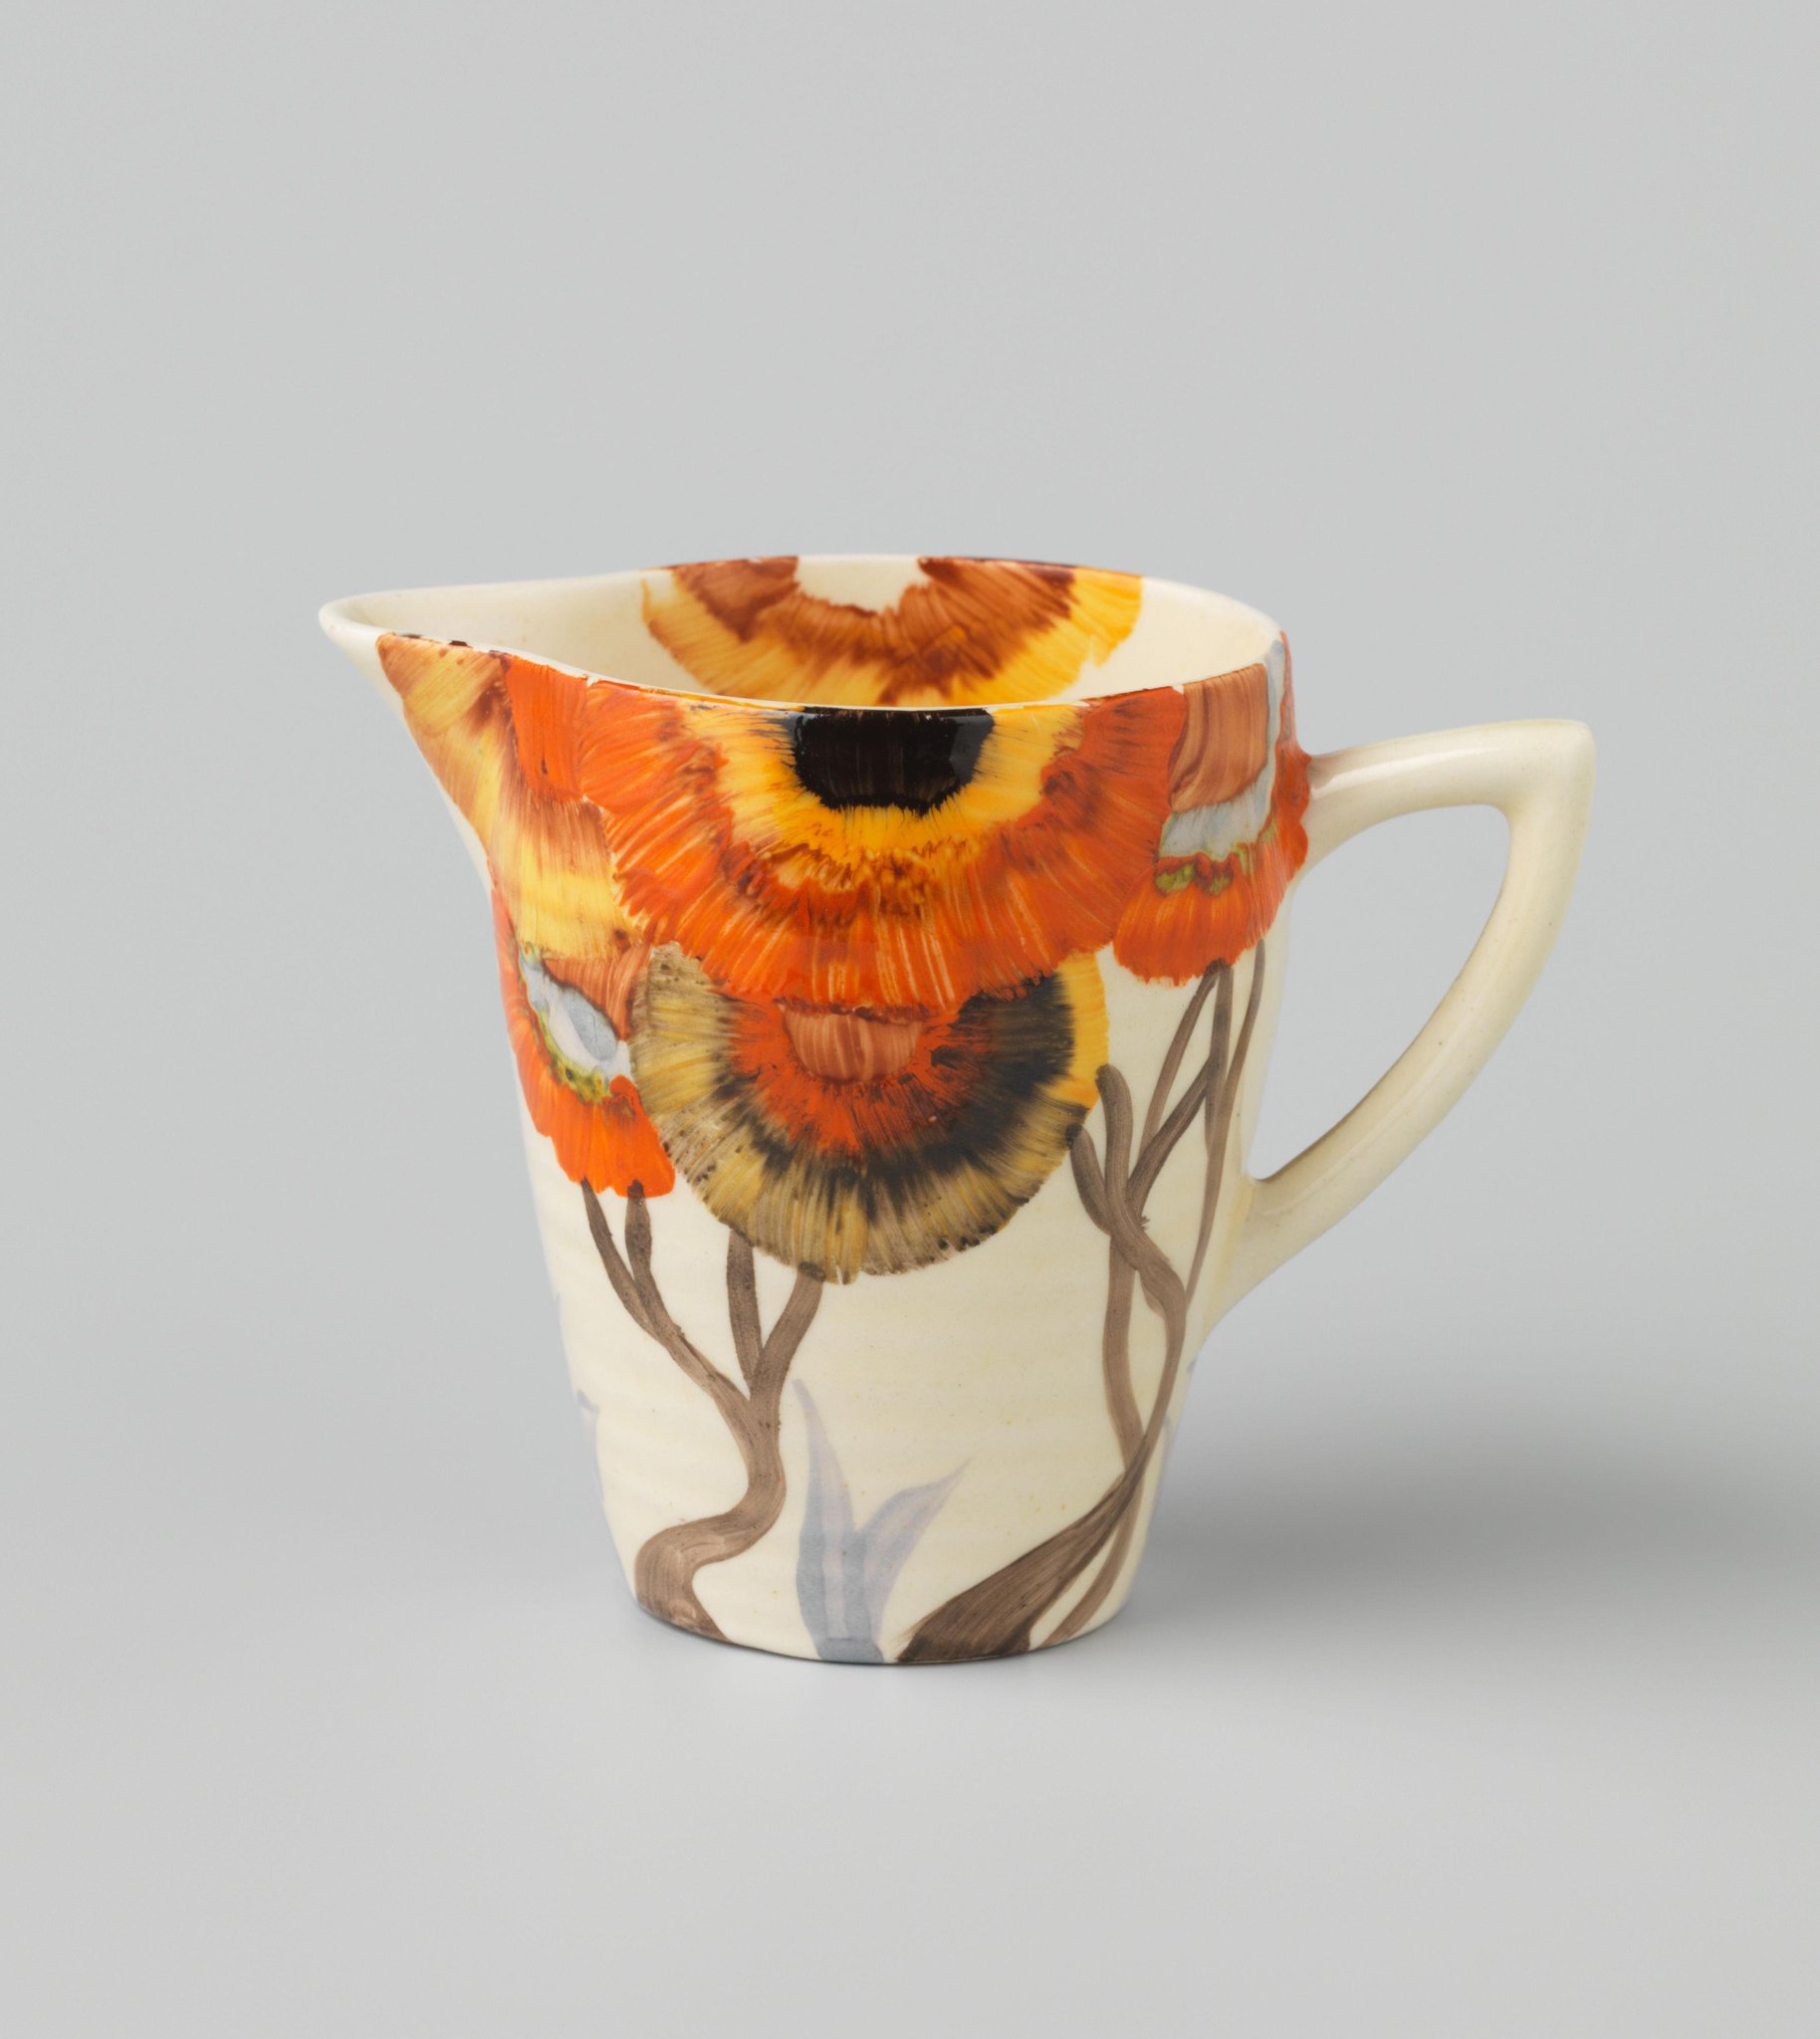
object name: milk jug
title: Melkkan met veelkleurig bloemendecor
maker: clarice cliff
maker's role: ceramicist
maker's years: 1899-1972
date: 1930-1940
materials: earthenware, chemical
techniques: painted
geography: england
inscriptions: mark: ‘HAND PAINTED, BIZARRE by CLARICE CLIFF, WILKINSON Ltd, ENGLAND, gestempeld in zwart’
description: Melkkan van aardewerk, veelkleurig beschilderd met bloemendecor. Onderdeel van theeservies.